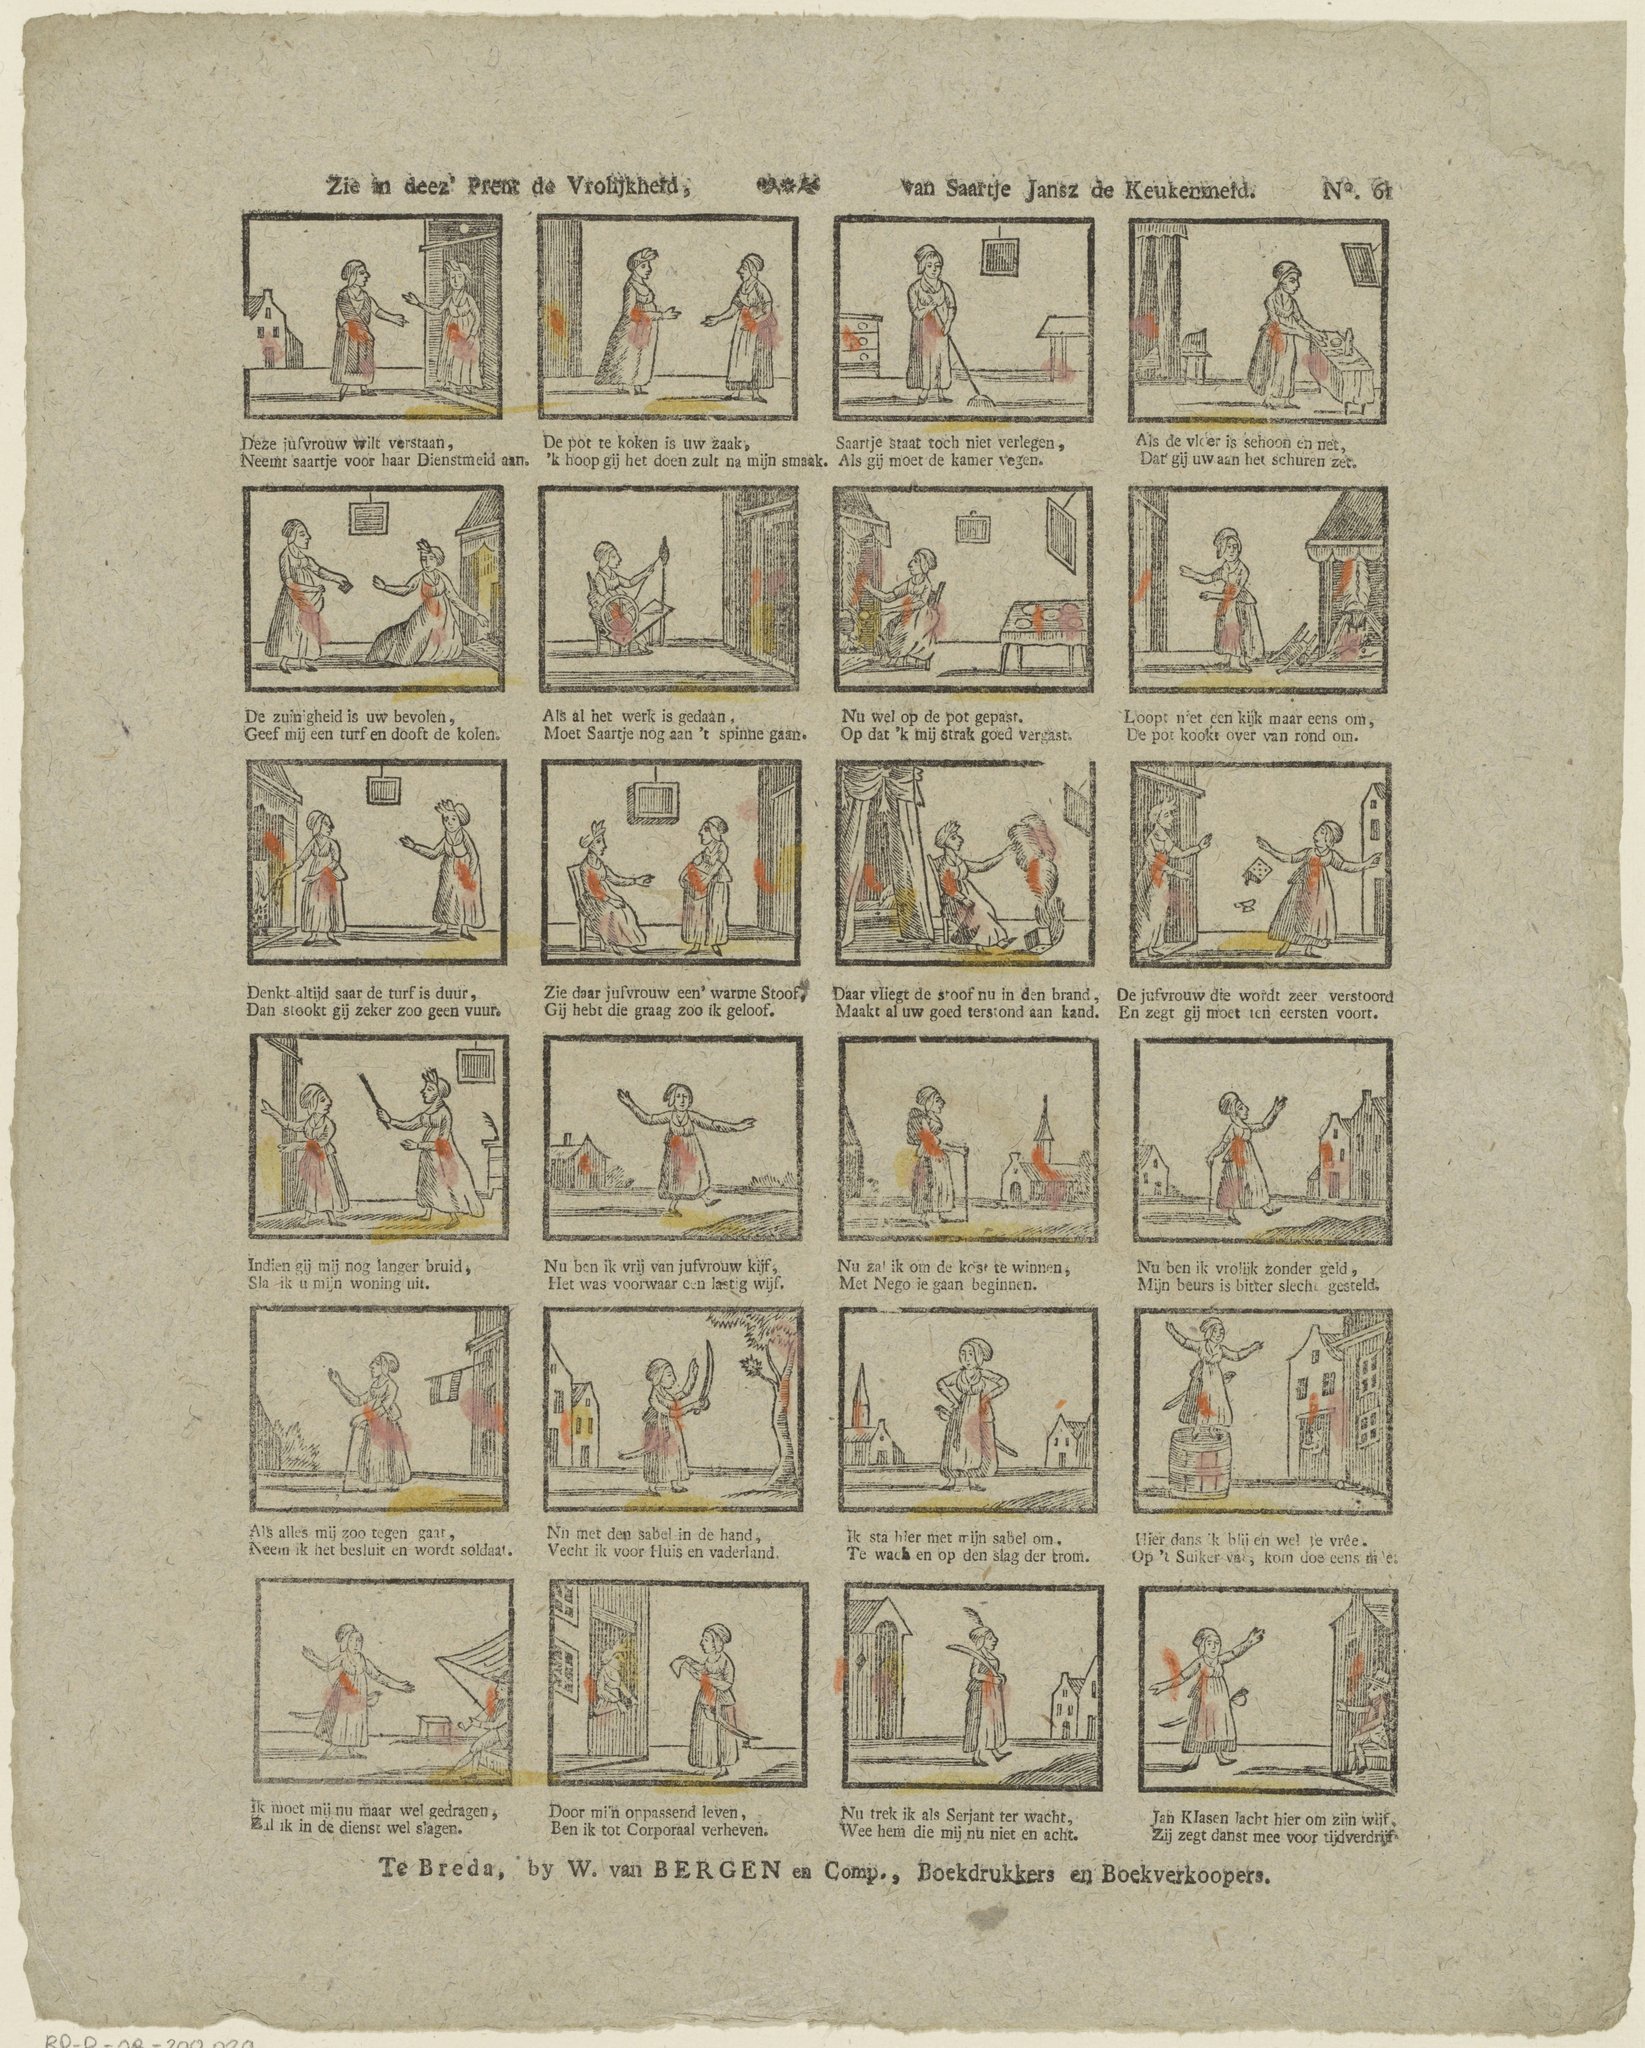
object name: print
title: Zie in deez' prent de vrolijkheid, van Saartje Jansz de keukenmeid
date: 1818-1828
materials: paper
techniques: colour, letterpress printing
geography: breda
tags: the soldier; the soldier's life, kitchen-maid, kitchen servant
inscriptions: collector's mark: Lugt 2760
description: Blad met 24 voorstellingen uit het leven van Saar Jansz.. Ze werkt als keukenmeid, maar wordt ontslagen omdat zij teveel van de dure turf gebruikt voor het koken. Daarna wordt zij soldaat. Onder elke afbeelding een tweeregelig vers. Genummerd rechtsboven: No. 61.